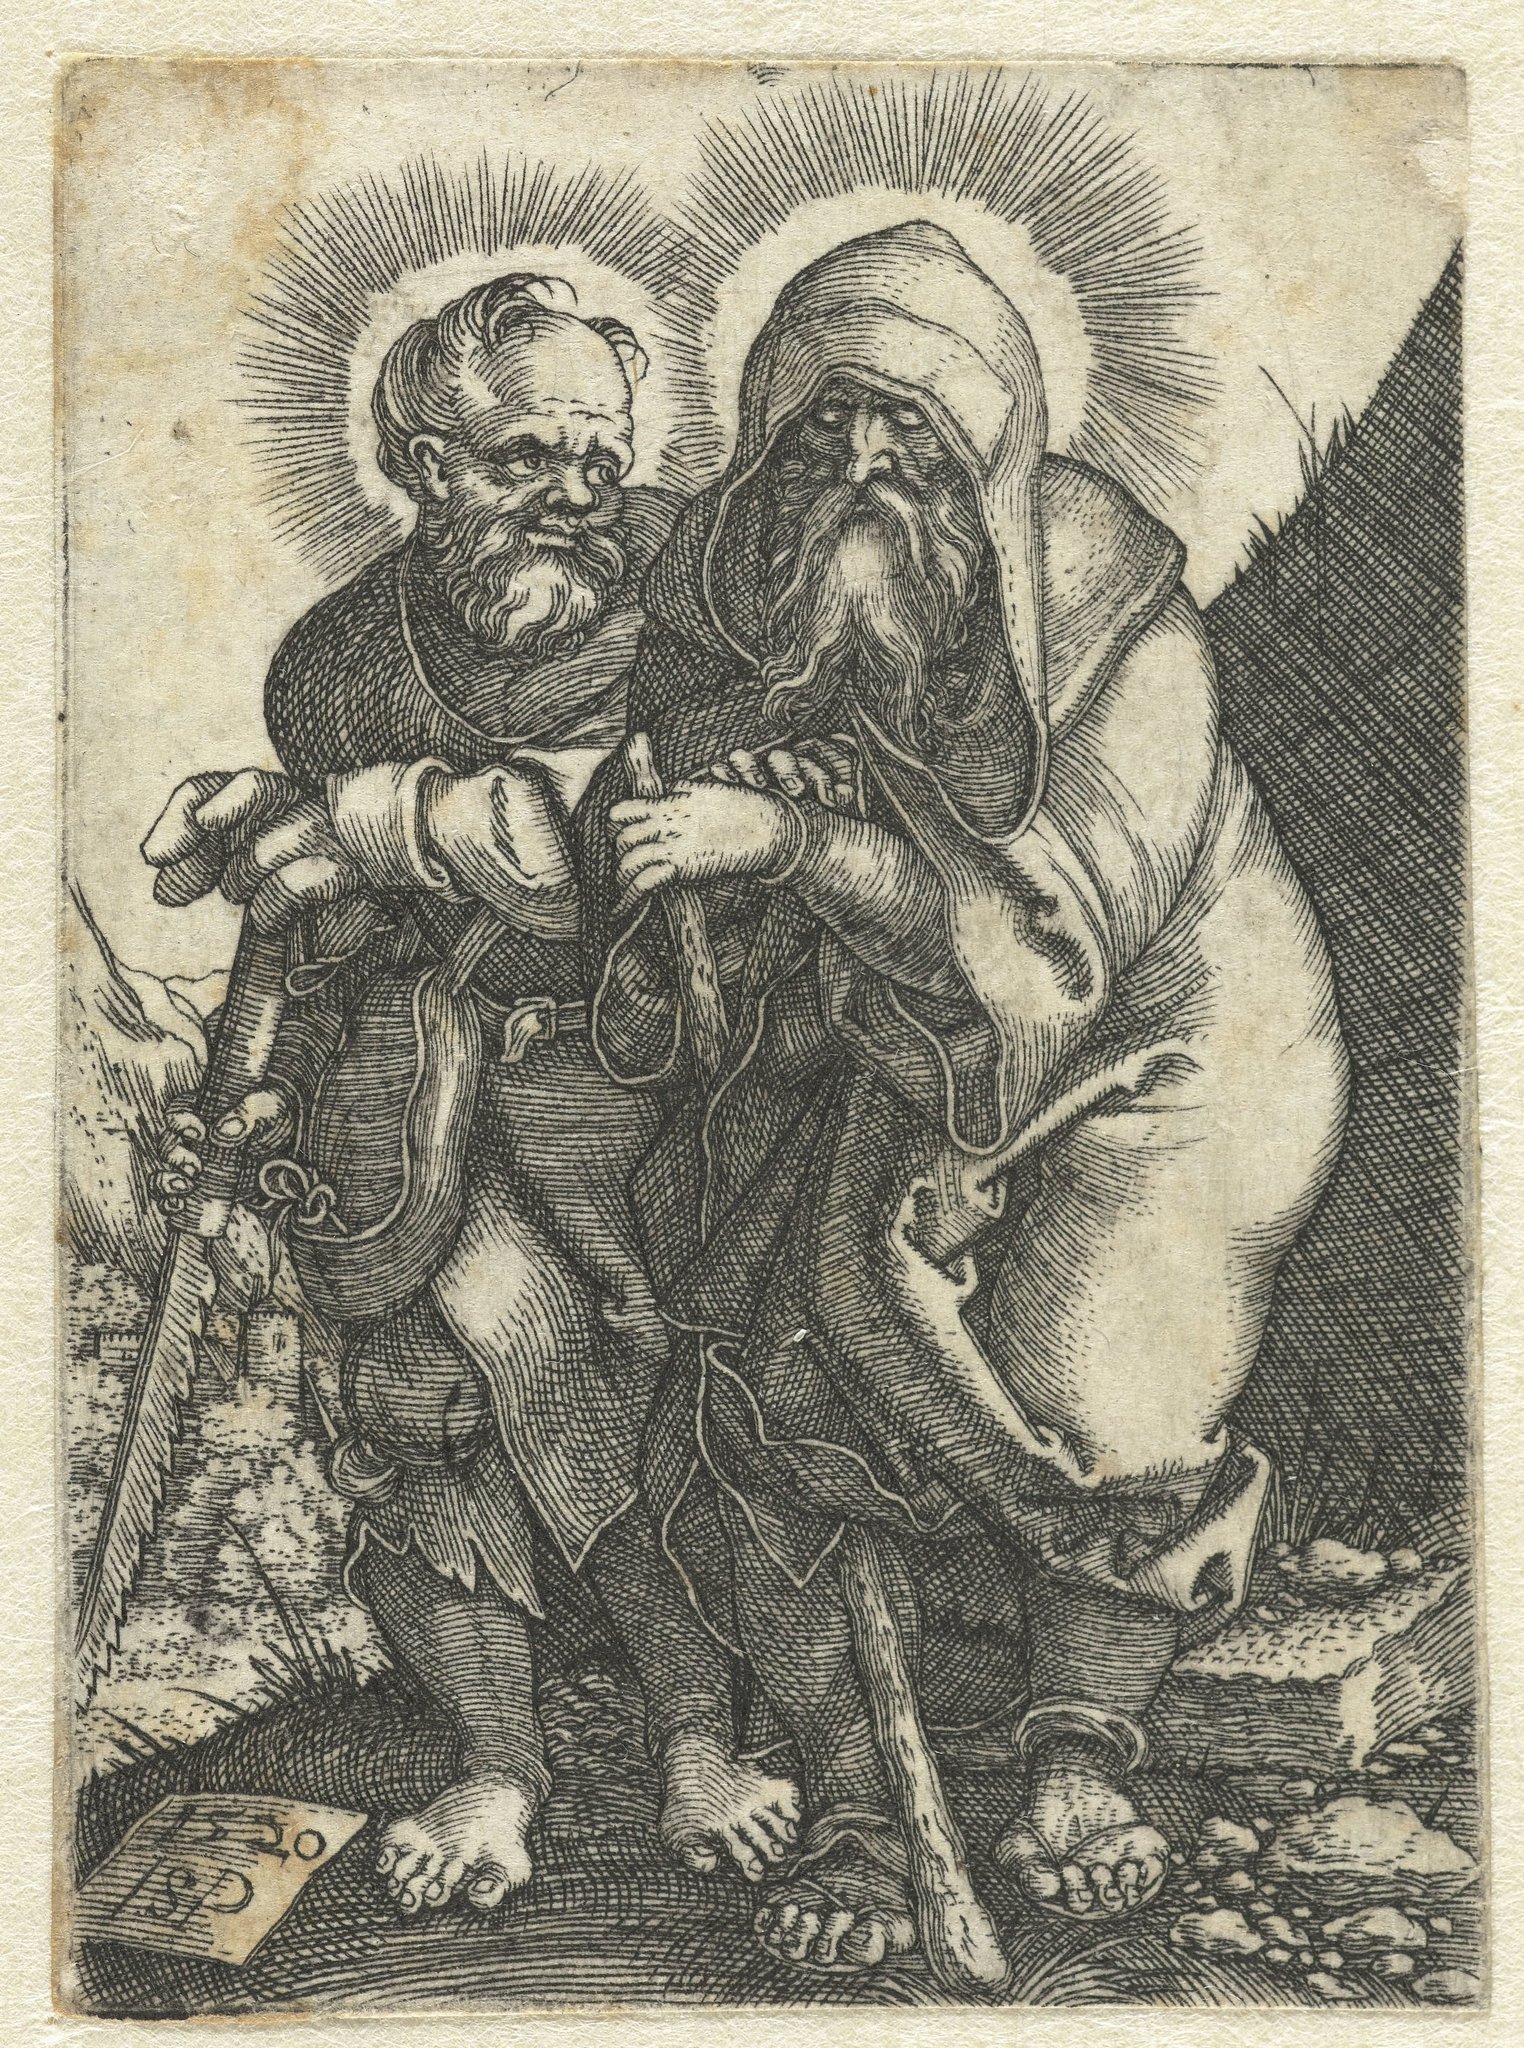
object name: print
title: Christus en de twaalf apostelen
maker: hans sebald beham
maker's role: designer, draughtsman, print maker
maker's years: 1500-1550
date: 1520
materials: paper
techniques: engraving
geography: nuremberg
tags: the apostle simon zelotes (or simon the canaanite); possible attributes: book, saw, scroll, male saints (with name)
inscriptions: collector's mark: Lugt 240